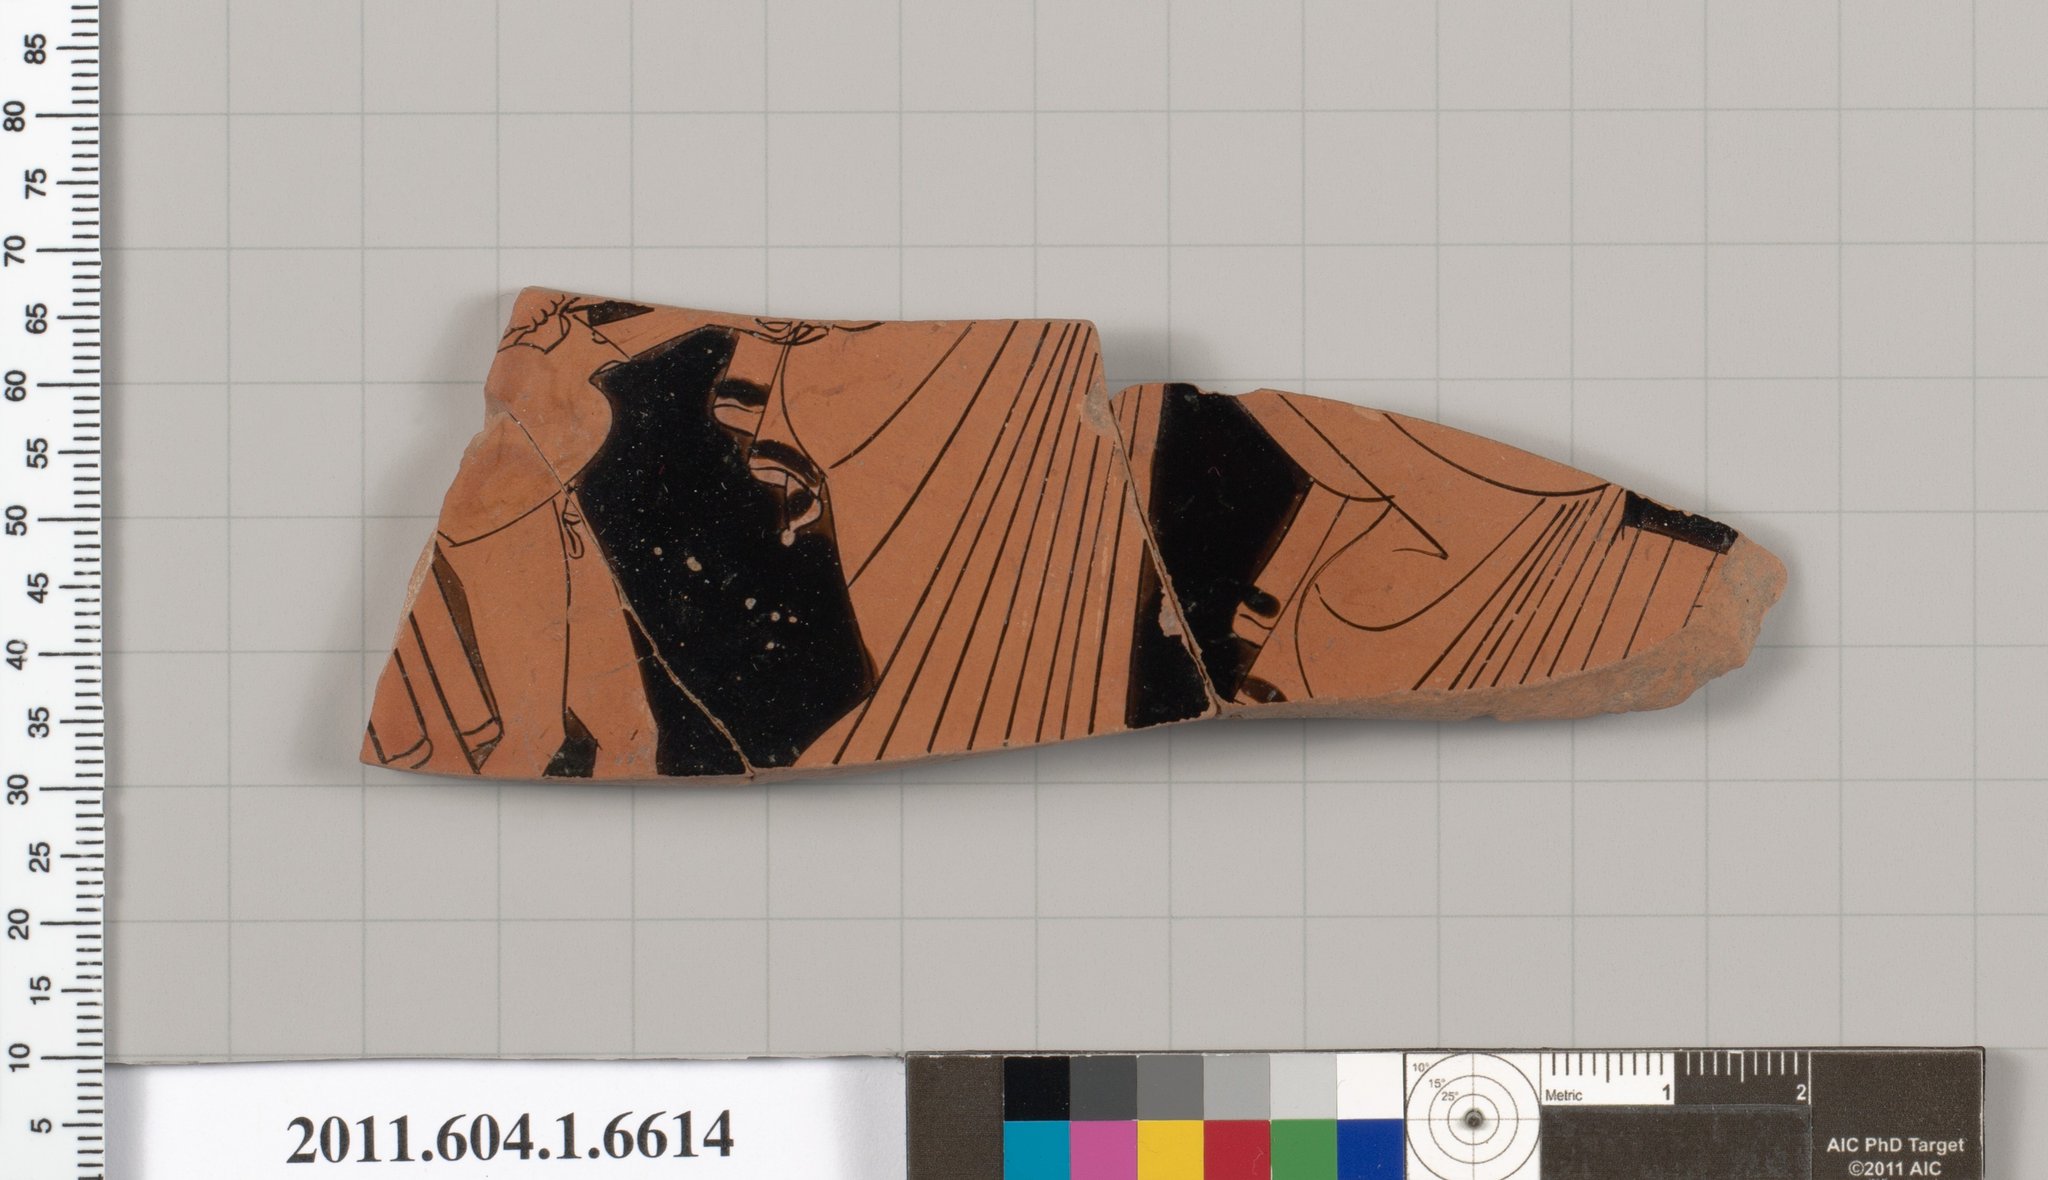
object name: kylix fragment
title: Terracotta fragment of a kylix (drinking cup)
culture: greek, attic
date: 490-470 BCE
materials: terracotta